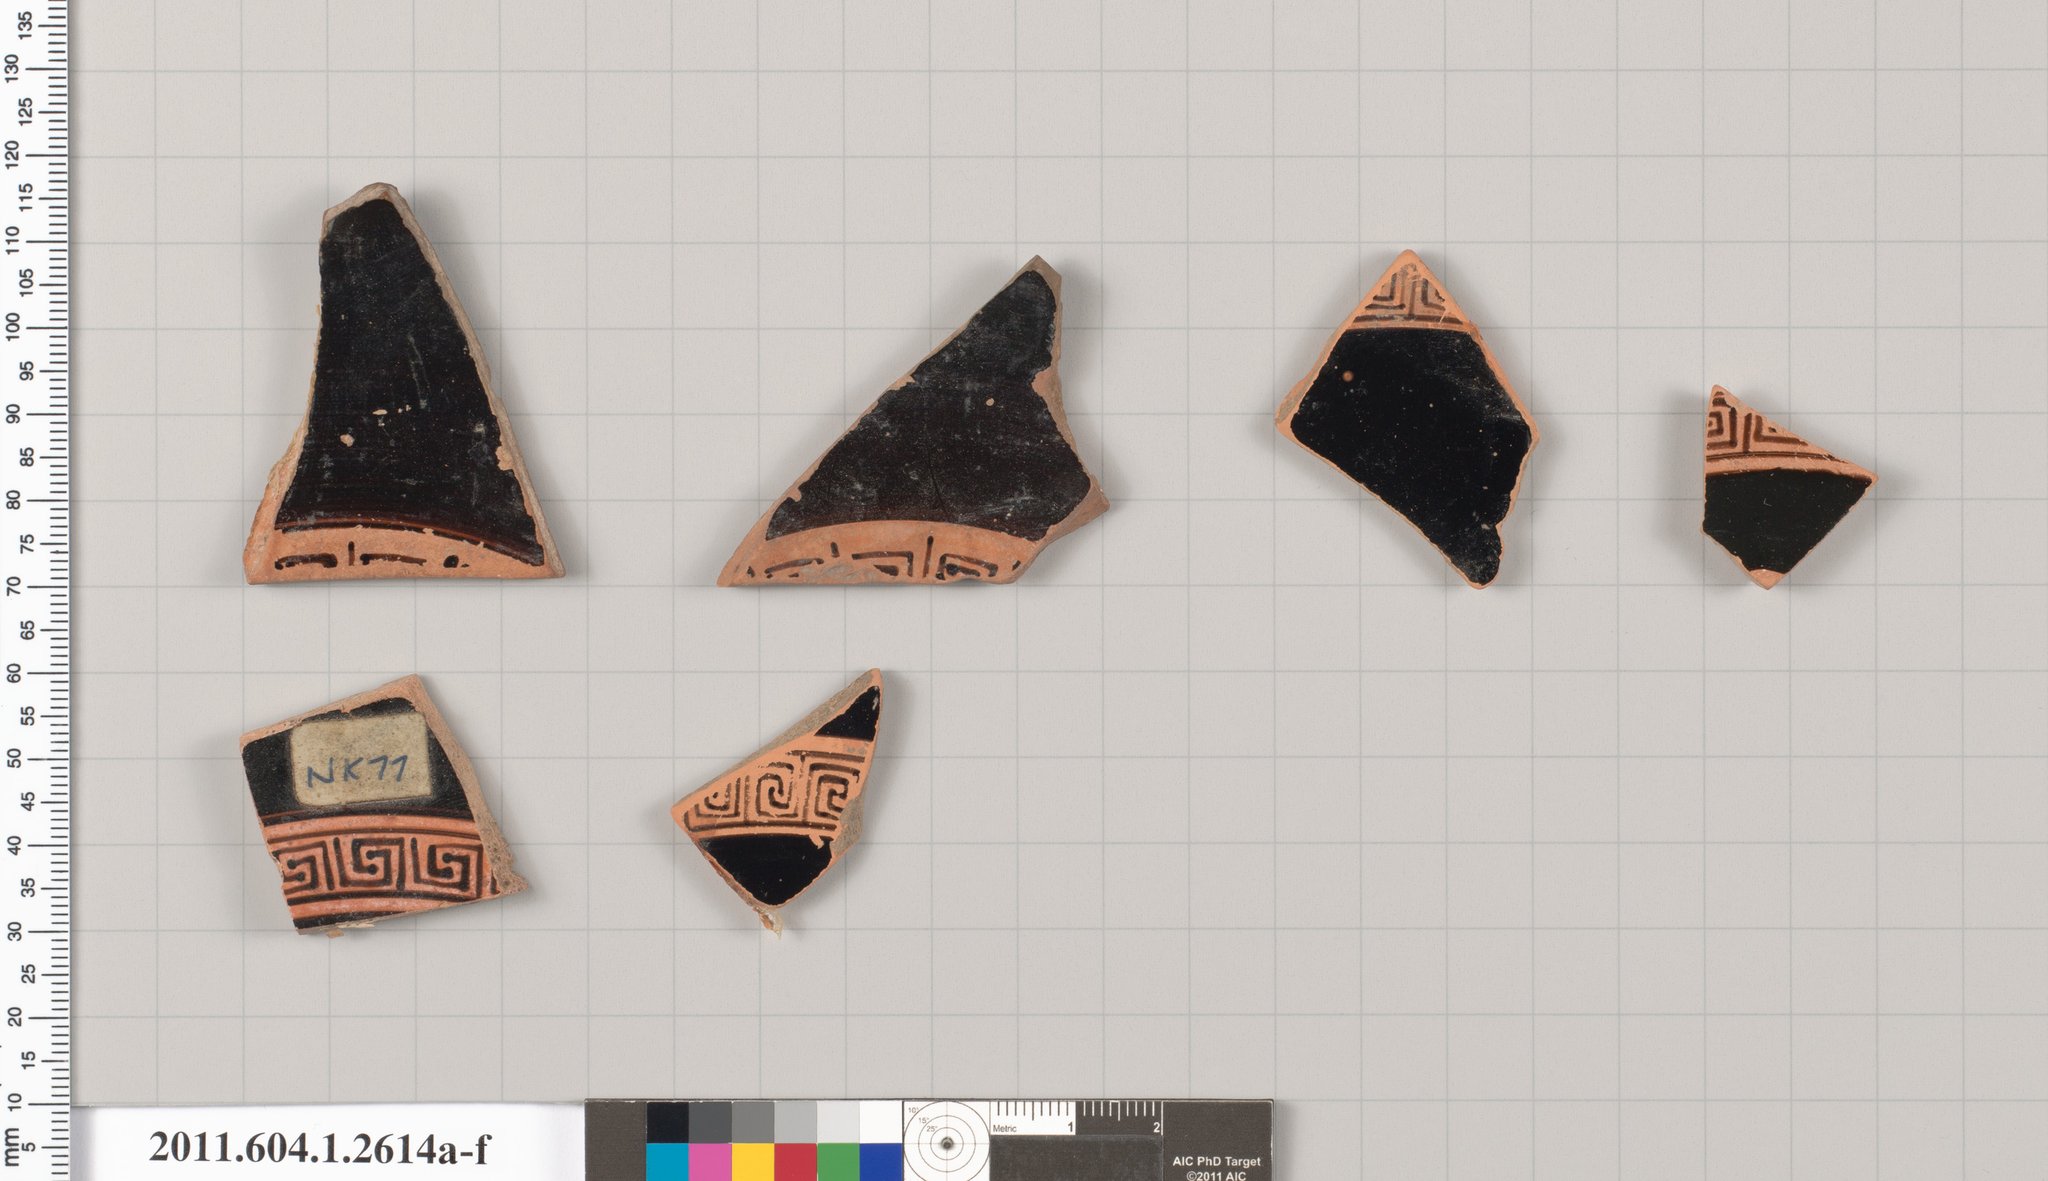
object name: kylix fragment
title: Terracotta fragments of kylikes (drinking cups)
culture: greek, attic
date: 500-480 BCE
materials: terracotta